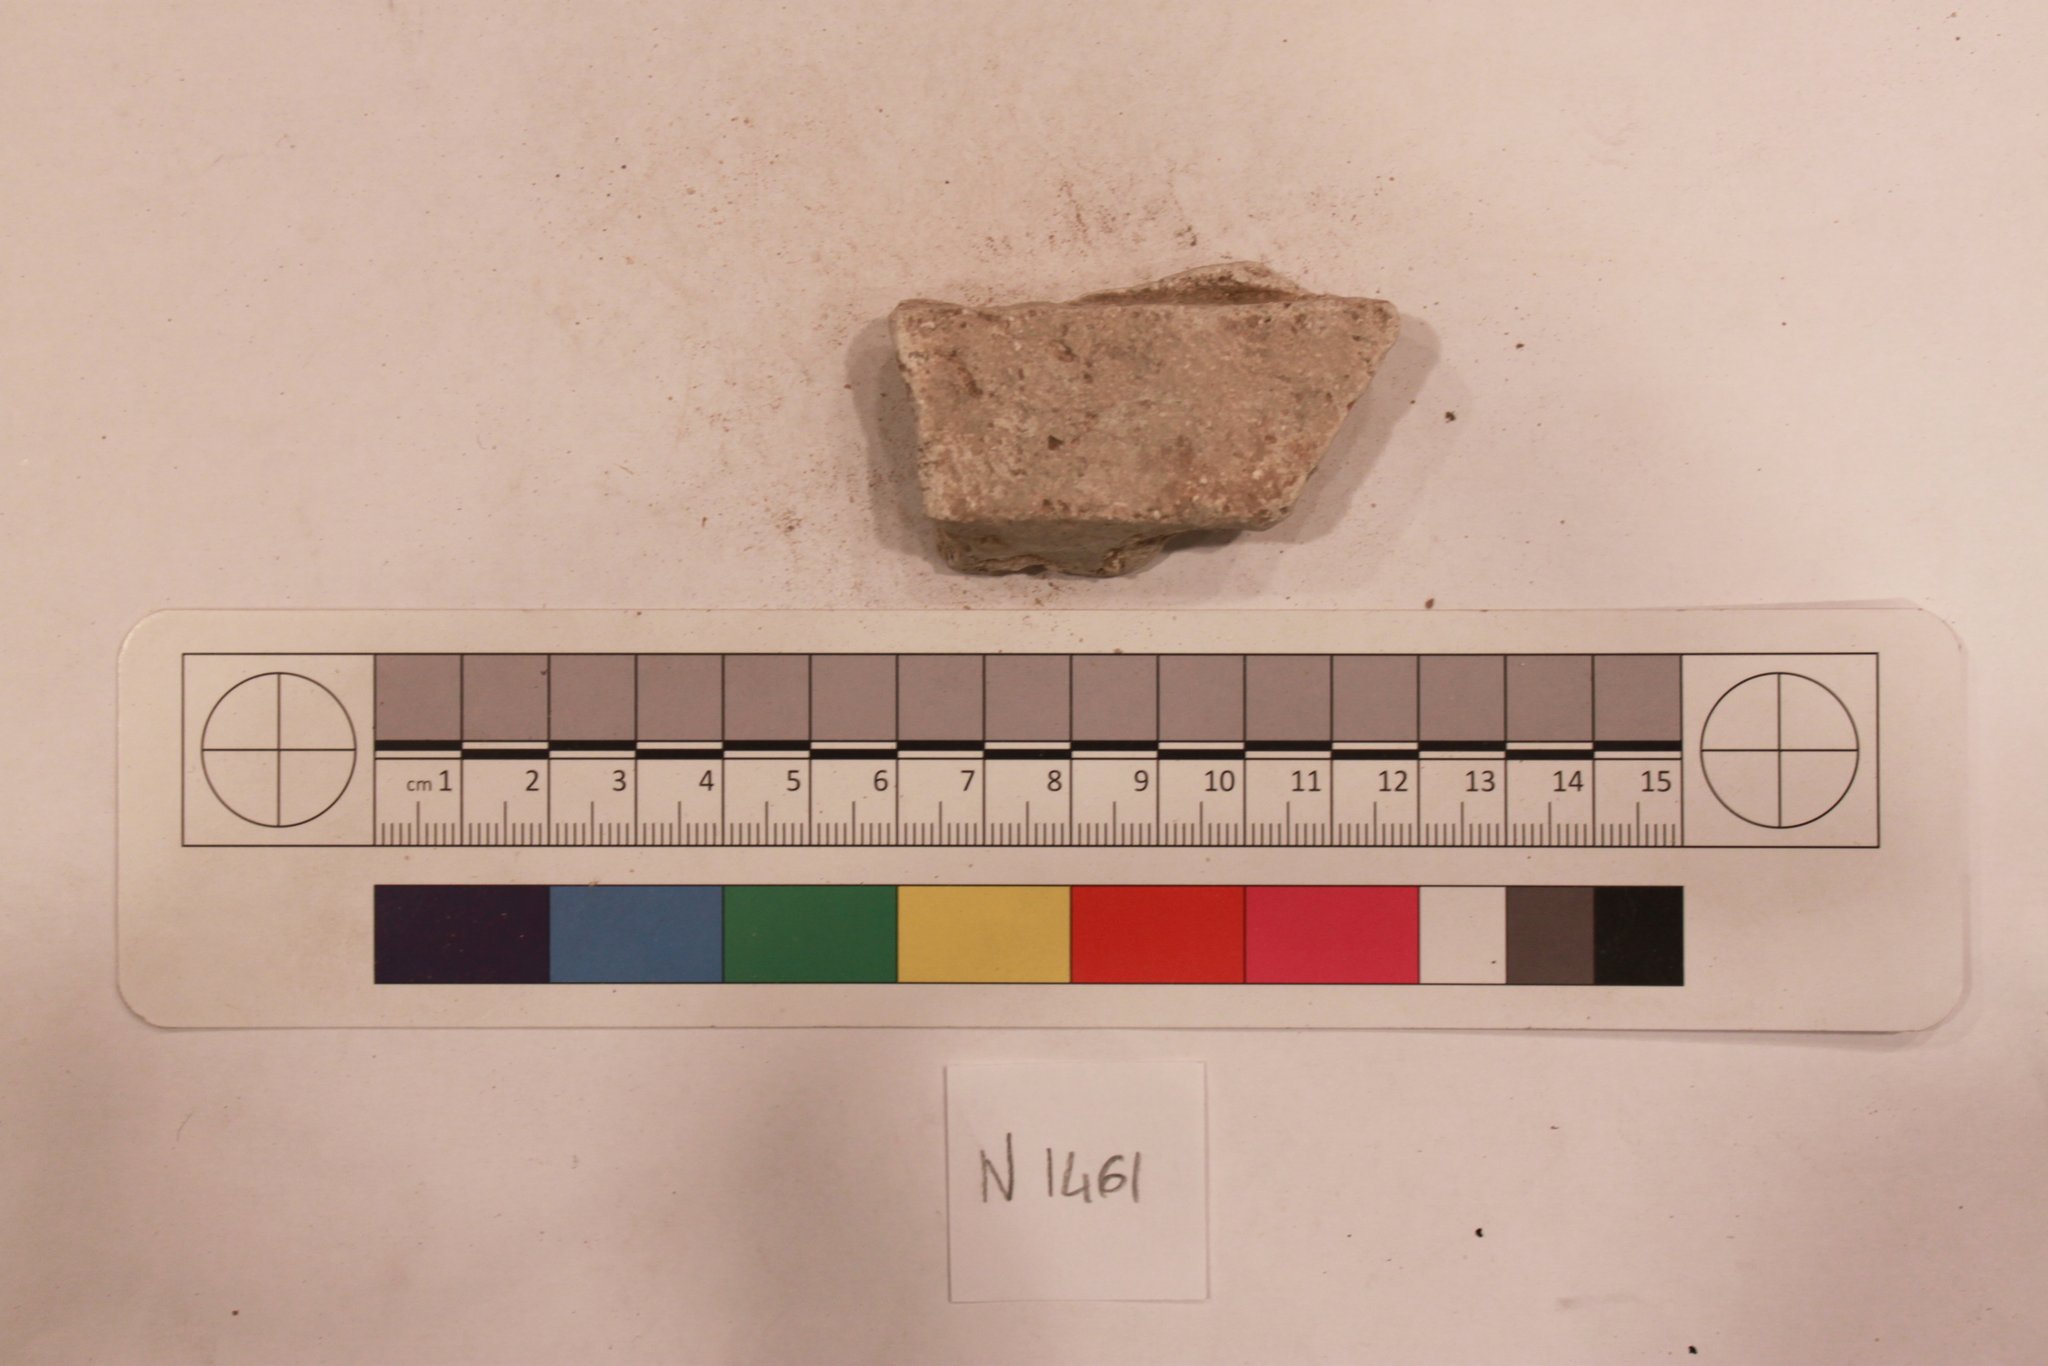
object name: fragment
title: Stucco Fragment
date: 701-1200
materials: plaster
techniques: carving, painting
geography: iran